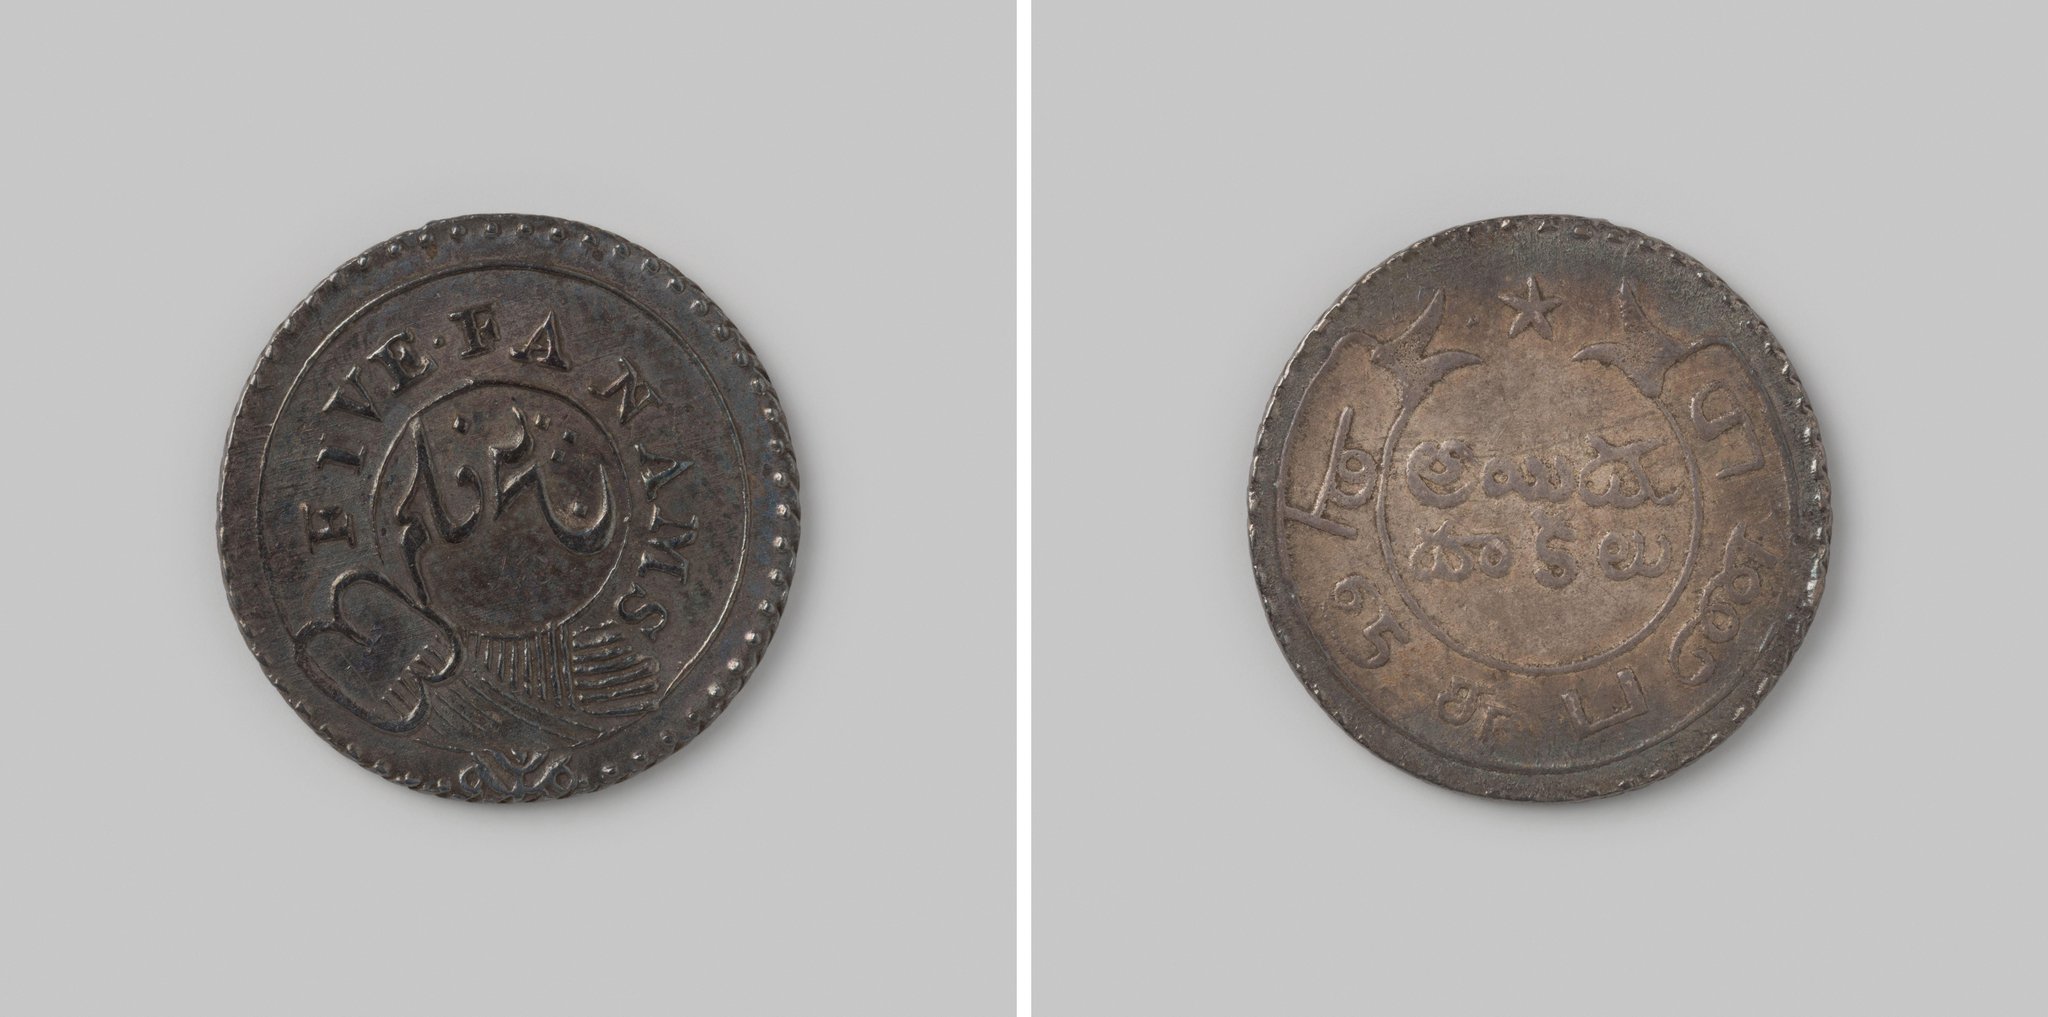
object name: coin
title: 5 fanams voor Madras in India van de Engelse Oostindische Compagnie (EIC), (1808)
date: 1808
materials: silver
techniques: striking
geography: chennai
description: Zilveren munt. Voorzijde: binnen cirkel, gevormd door ceintuur met gesp, waarde-aanduiding in het Engels: five fanams, op een regel waarde-aanduiding in Arabische lettertekens. Keerzijde: binnen cirkel, gevormd door lint, waarop waarde-aanduiding in het Tamil, in twee regels waarde-aanduiding in het Telugu. Bovenaan, tussen uiteinden van het lint, een ster. Kabelrand.